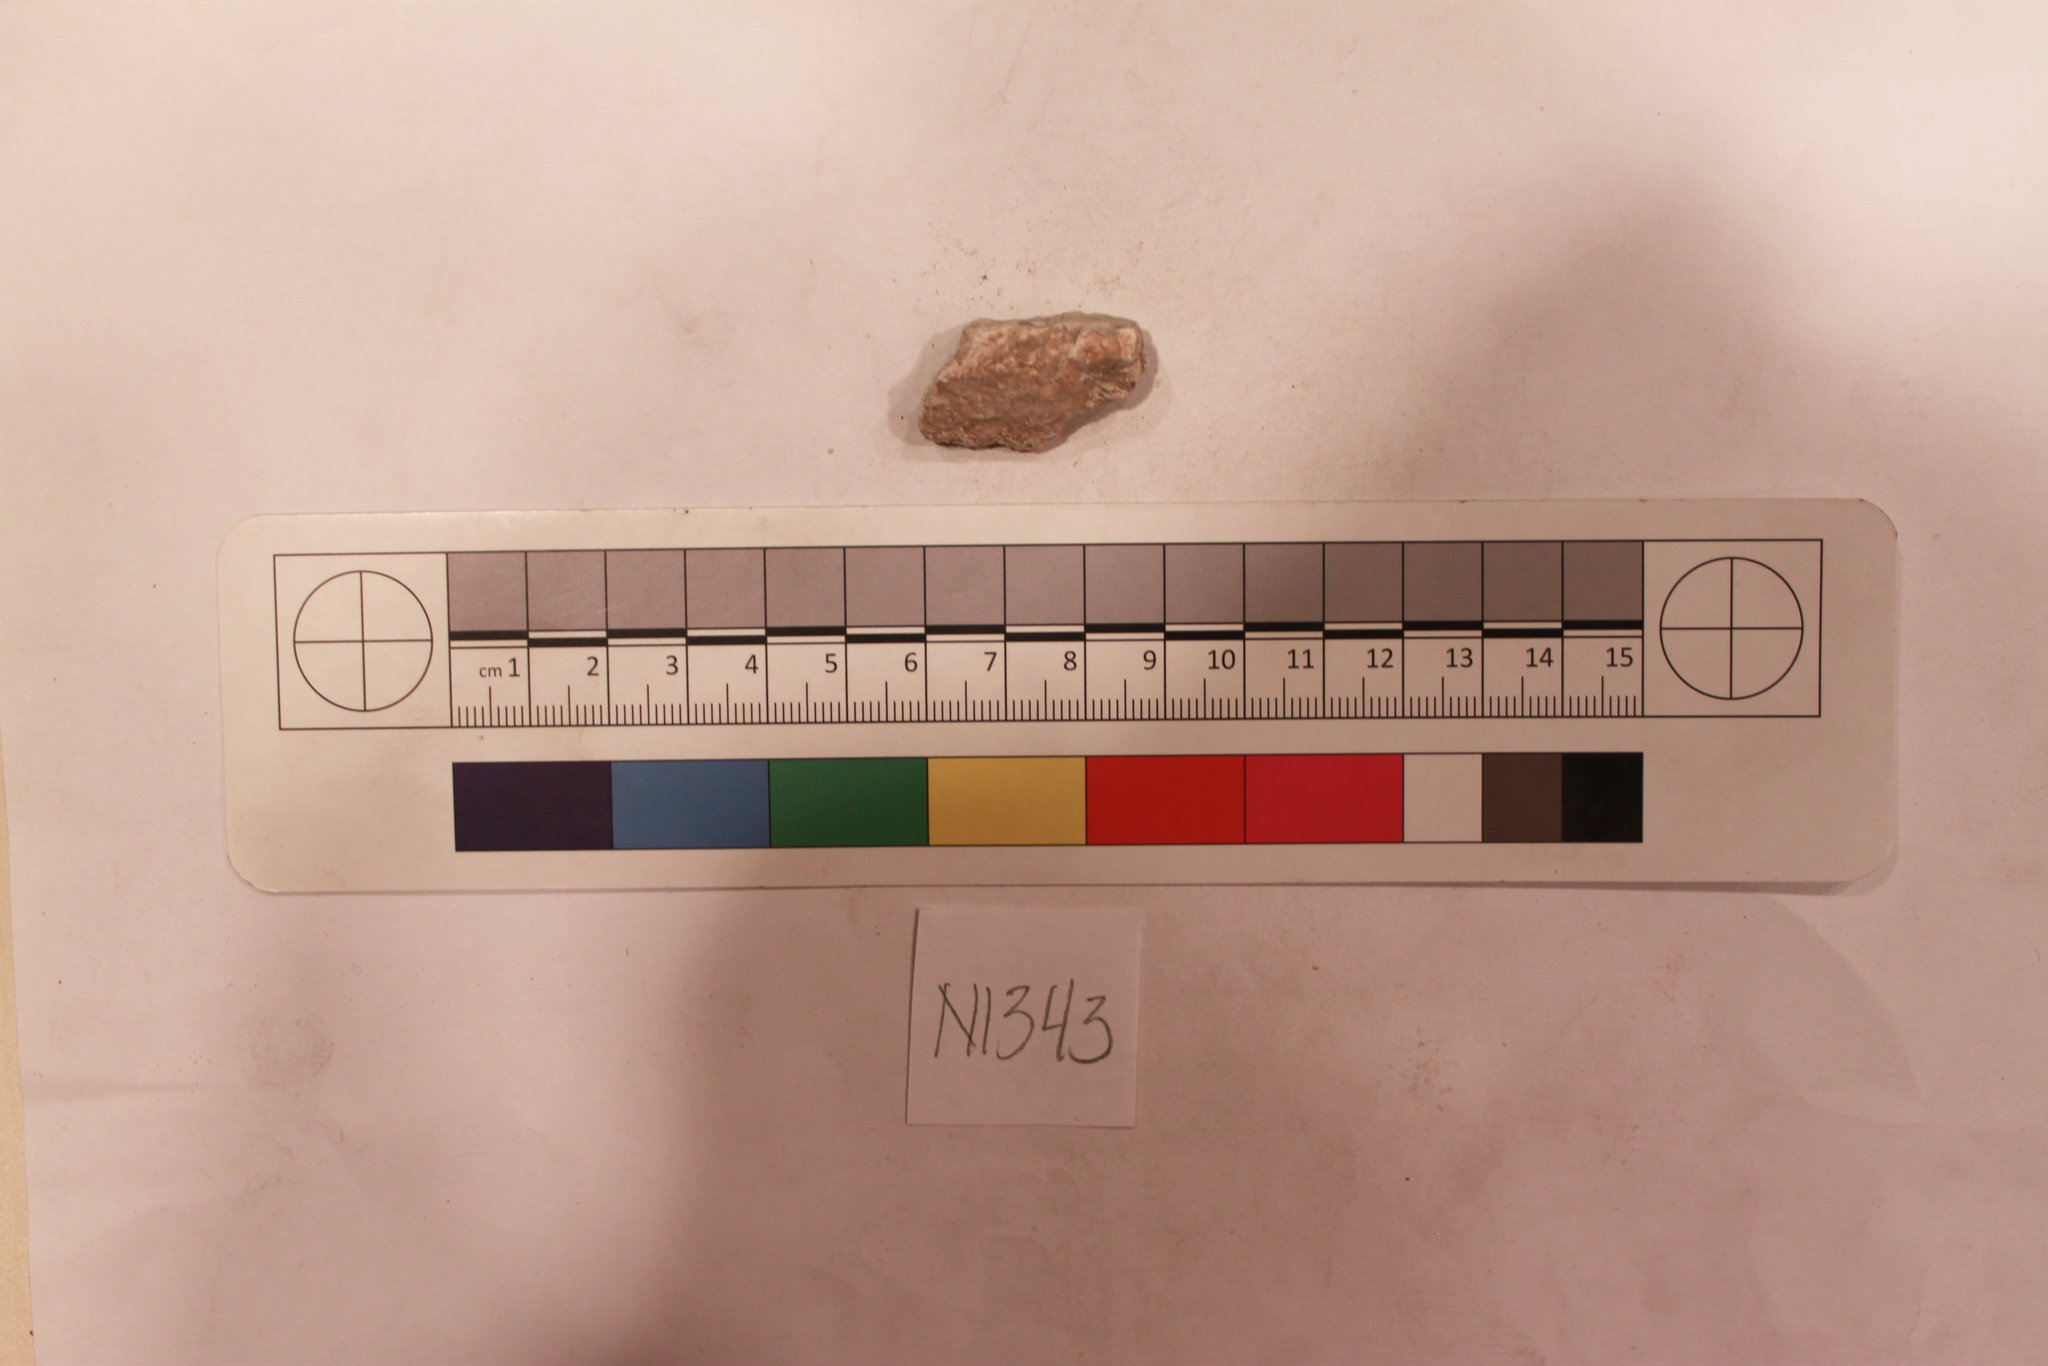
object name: fragment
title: Stucco Fragment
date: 701-1200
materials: plaster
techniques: carving, painting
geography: iran